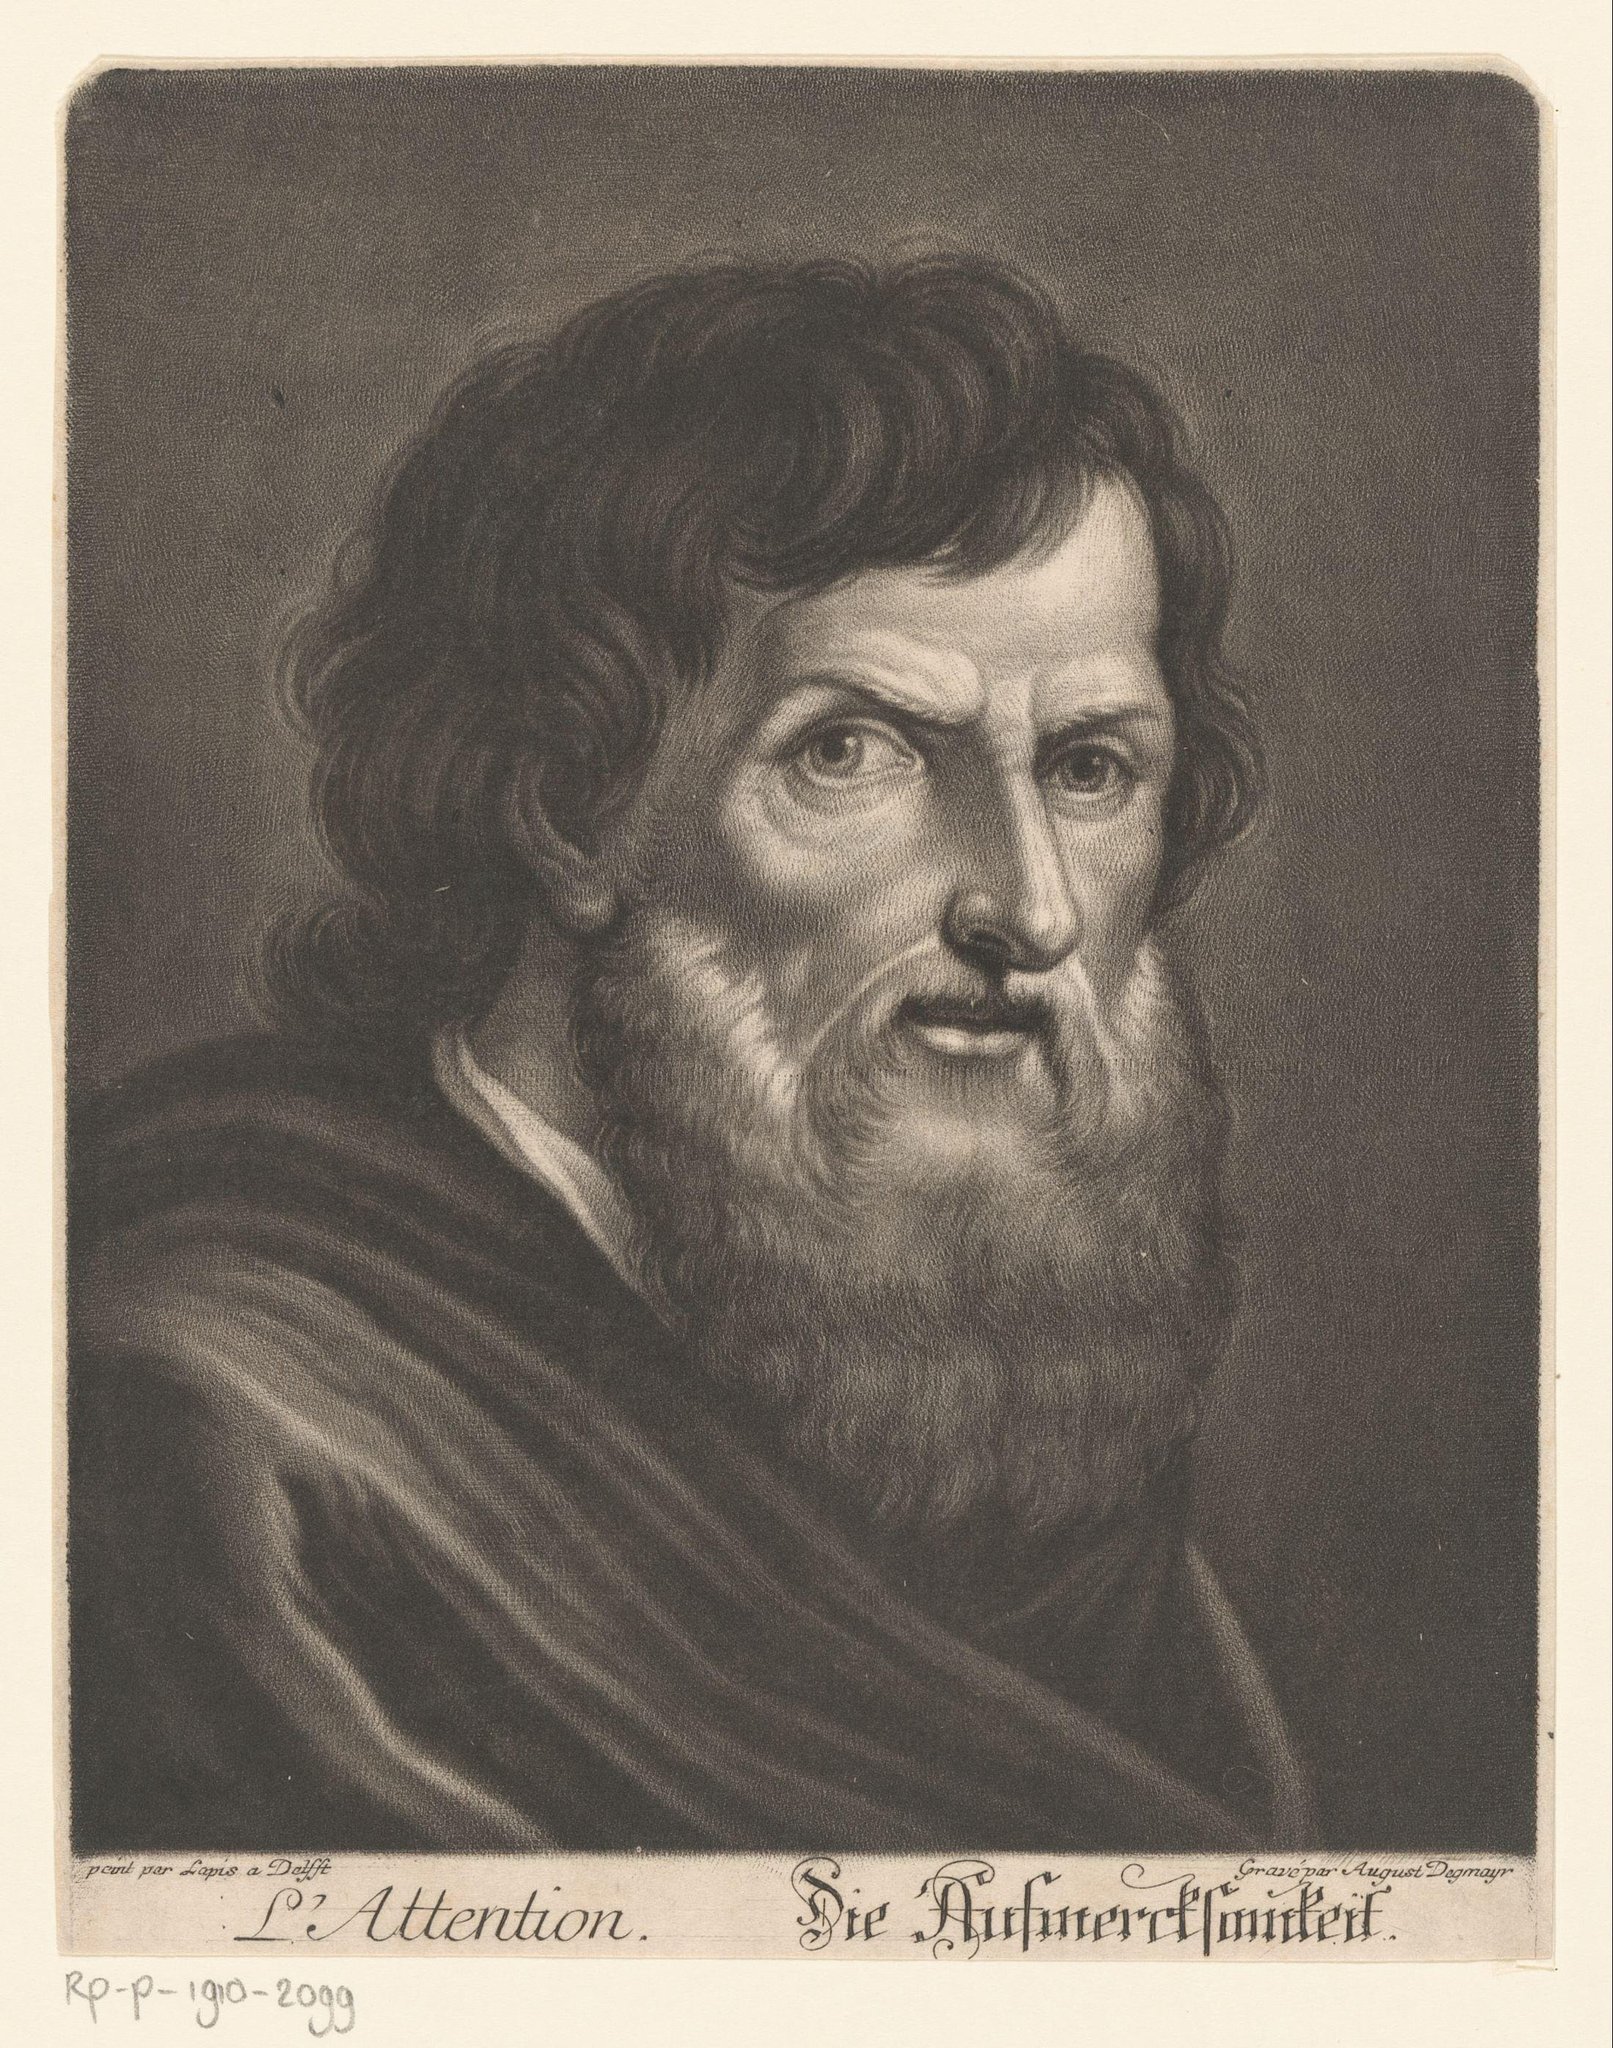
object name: print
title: Aandachtig kijkende man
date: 1733-1783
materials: paper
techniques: mezzotint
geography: delft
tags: head (human), attention, concentration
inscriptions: collector's mark: Lugt 2228